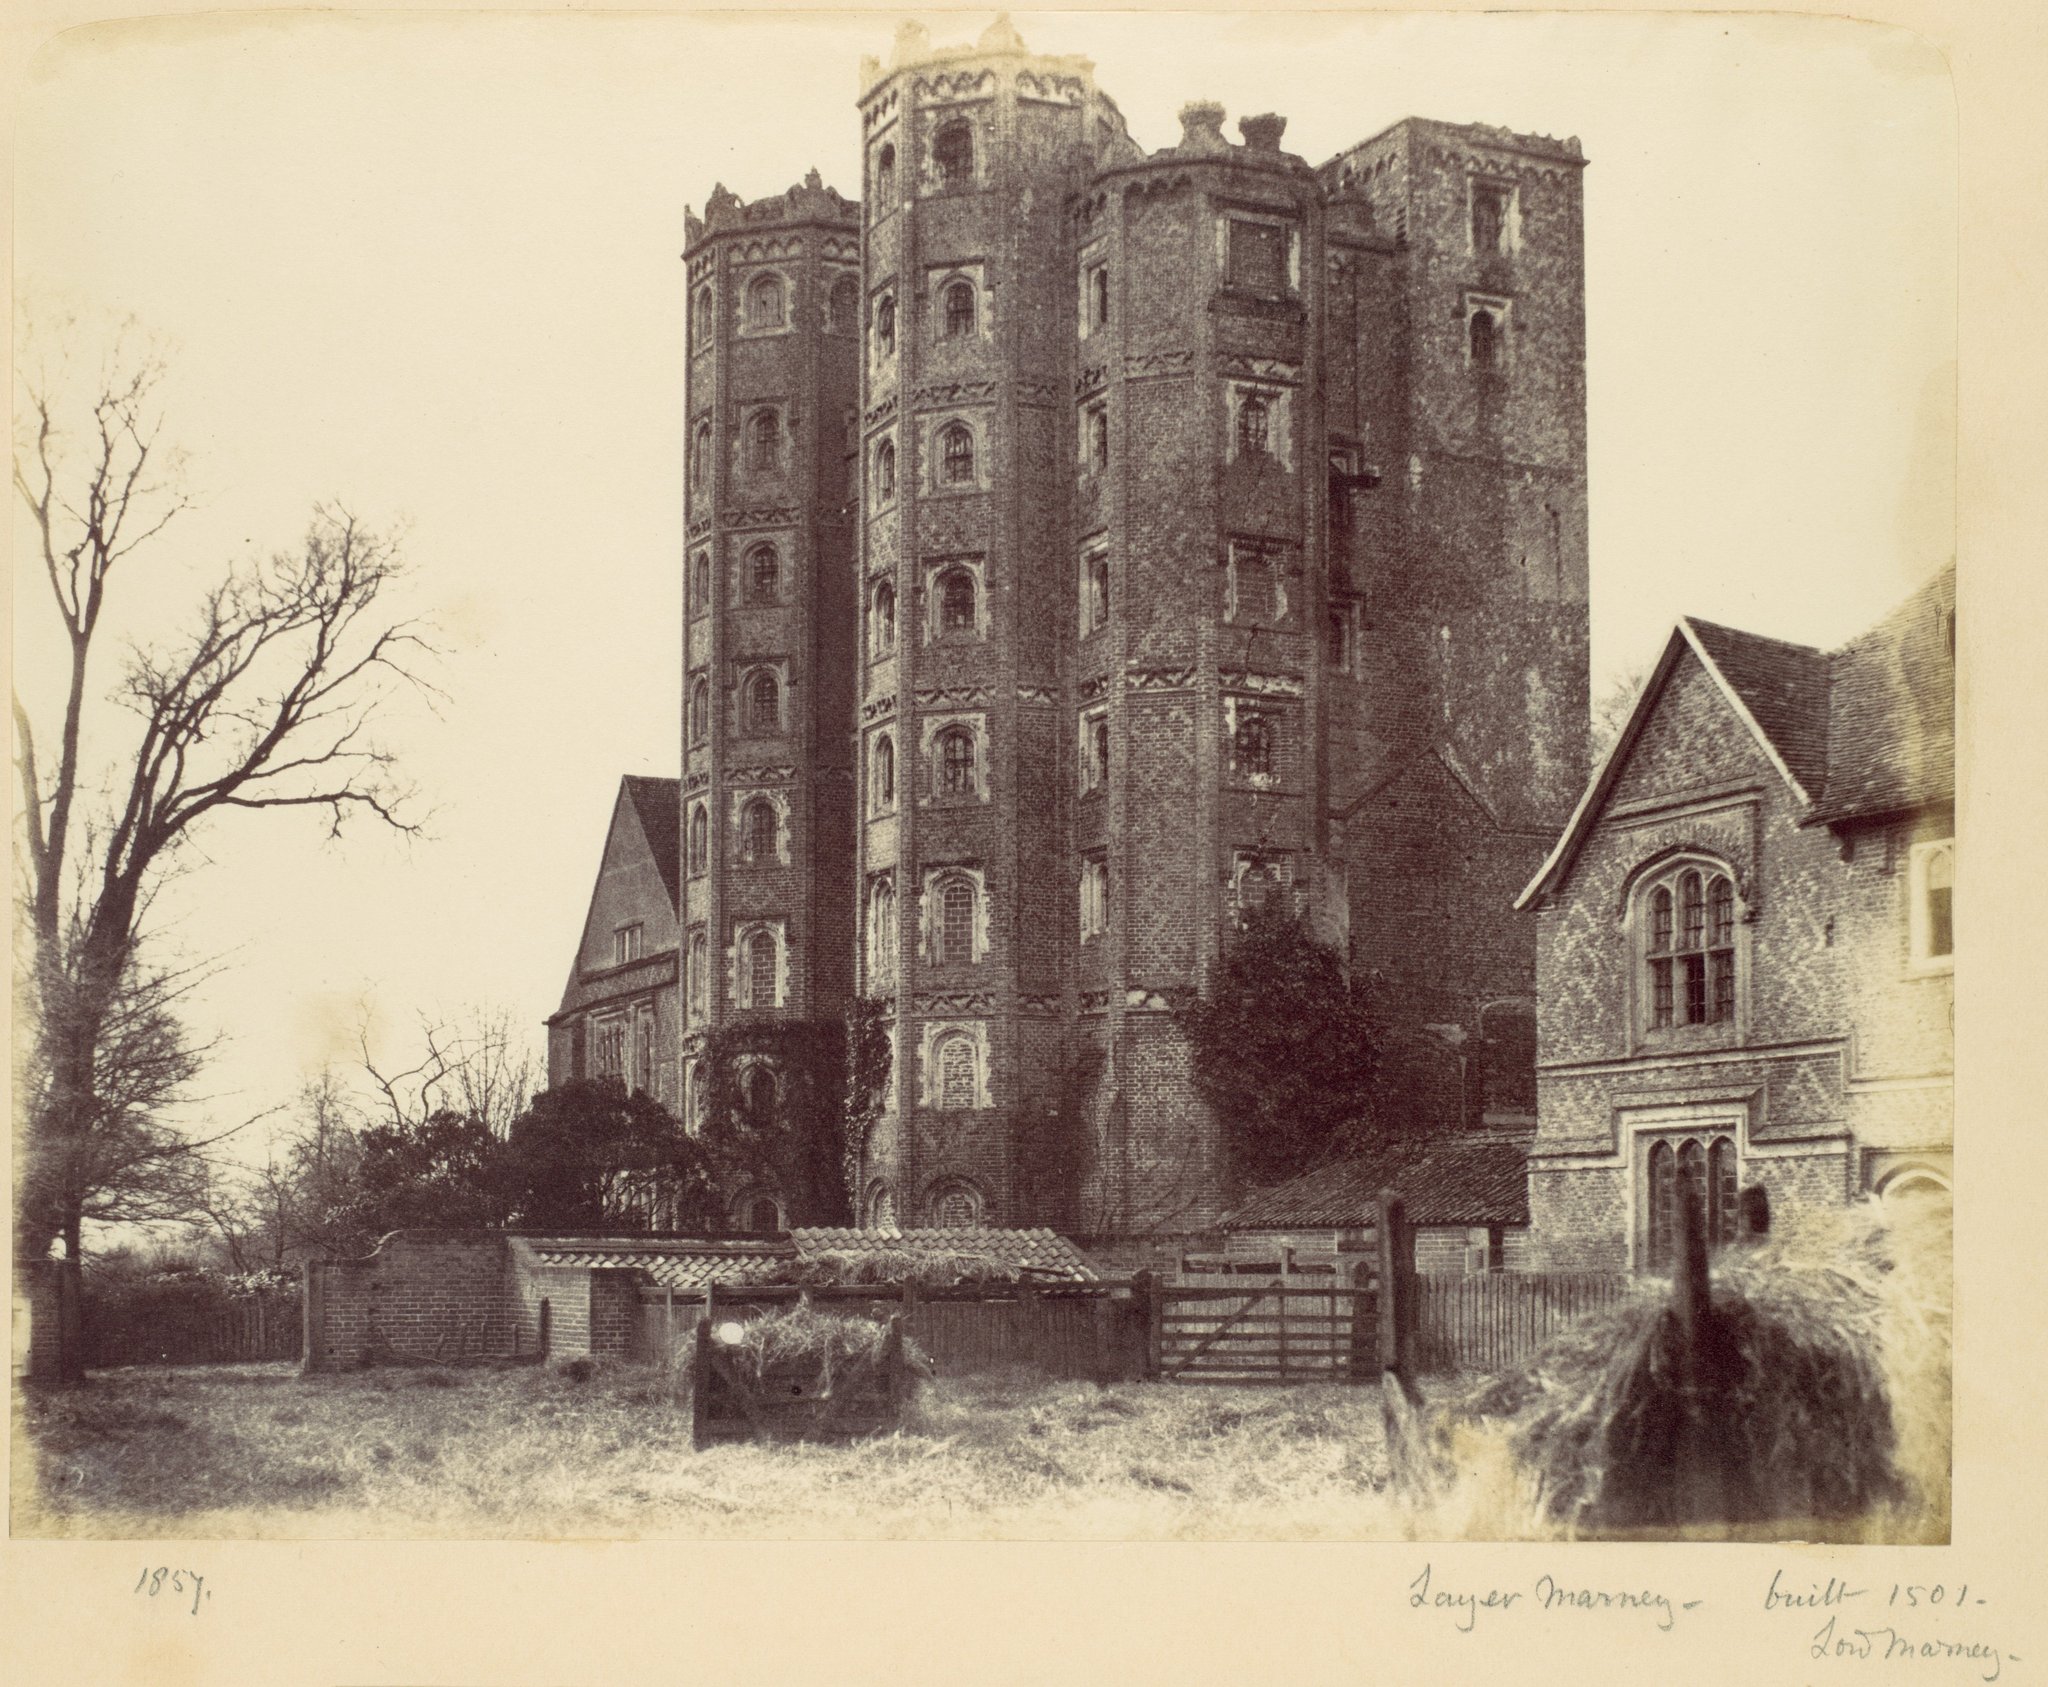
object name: photograph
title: Layer Marney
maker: alfred capel cure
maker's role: artist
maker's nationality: british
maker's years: 1826-1896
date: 1857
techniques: albumen silver print, paper negative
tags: architecture,buildings